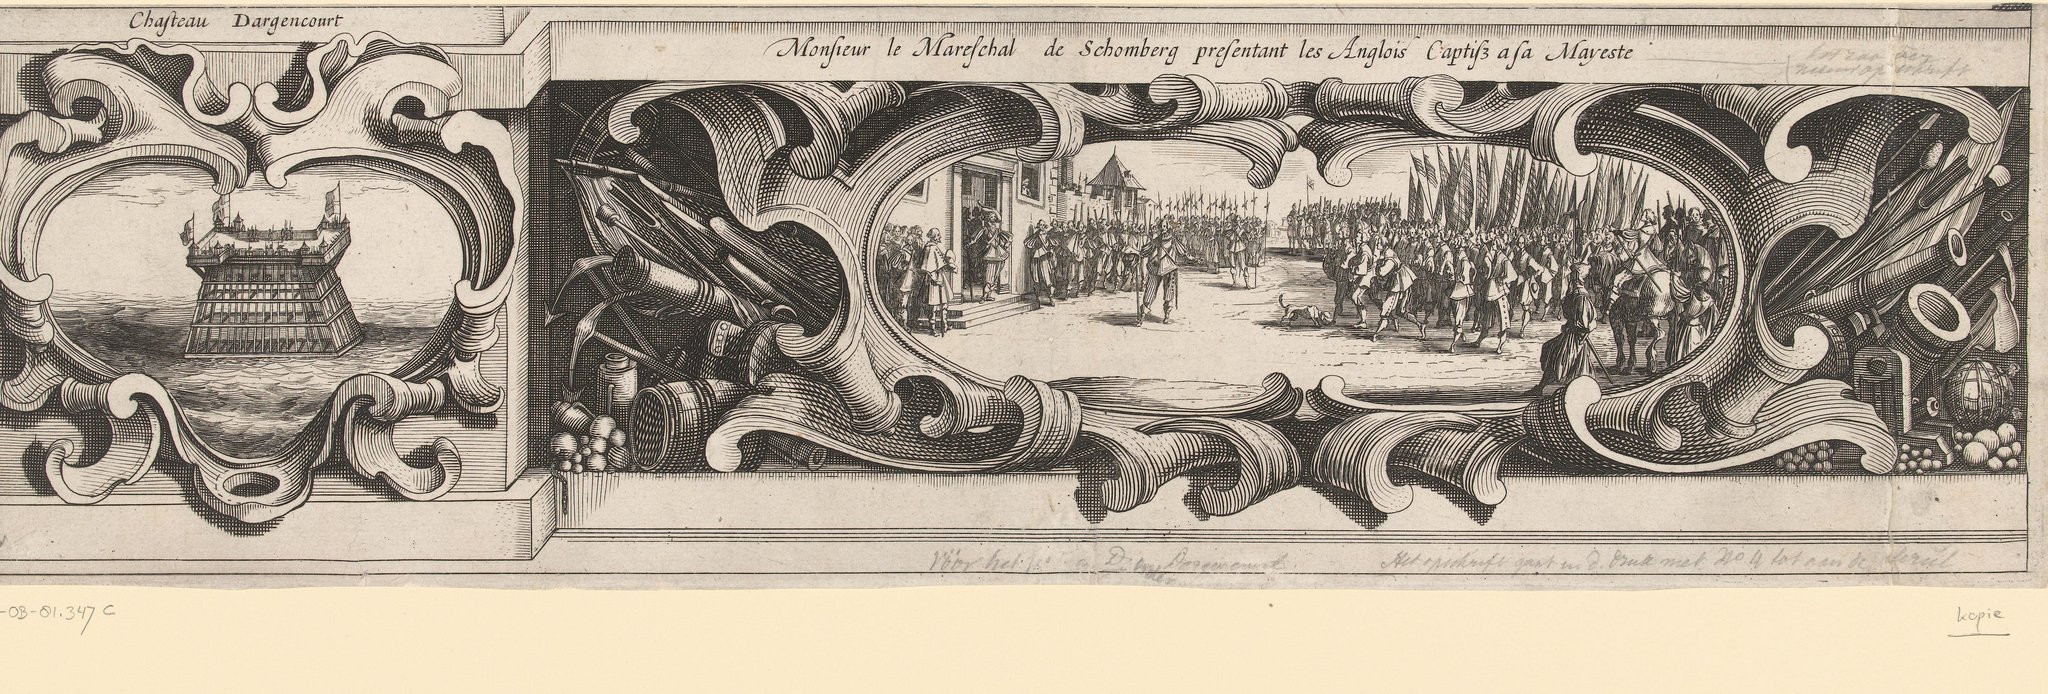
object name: print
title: Chasteau Dargencourt / Monsieur le Mareschal de Schomberg presentant les Anglois Captifs a sa Mayeste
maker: Anonymous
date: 1631-1639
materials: paper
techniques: engraving, etching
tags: paris, armand-jean du plessis hertog van richelieu, lodewijk xiii (koning van frankrijk), ornament ~ cartouche, prisoner of war (after the battle), temporary fortifications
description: Grote prent van het beleg van het hugenotenbolwerk La Rochelle in de jaren 1627 en 1628, dat werd uitgevoerd in opdracht van de Franse koning door het Franse leger onder aanvoering van kardinaal Richelieu. Randwerk, deel linksonder (kopie). Op dit blad links een voorstelling van een houten toren in zee en midden; rechts een voorstelling (omgeven door militaire attributen) van Engelse krijgsgevangenen die voor koning Lodewijk XIII worden geleid.